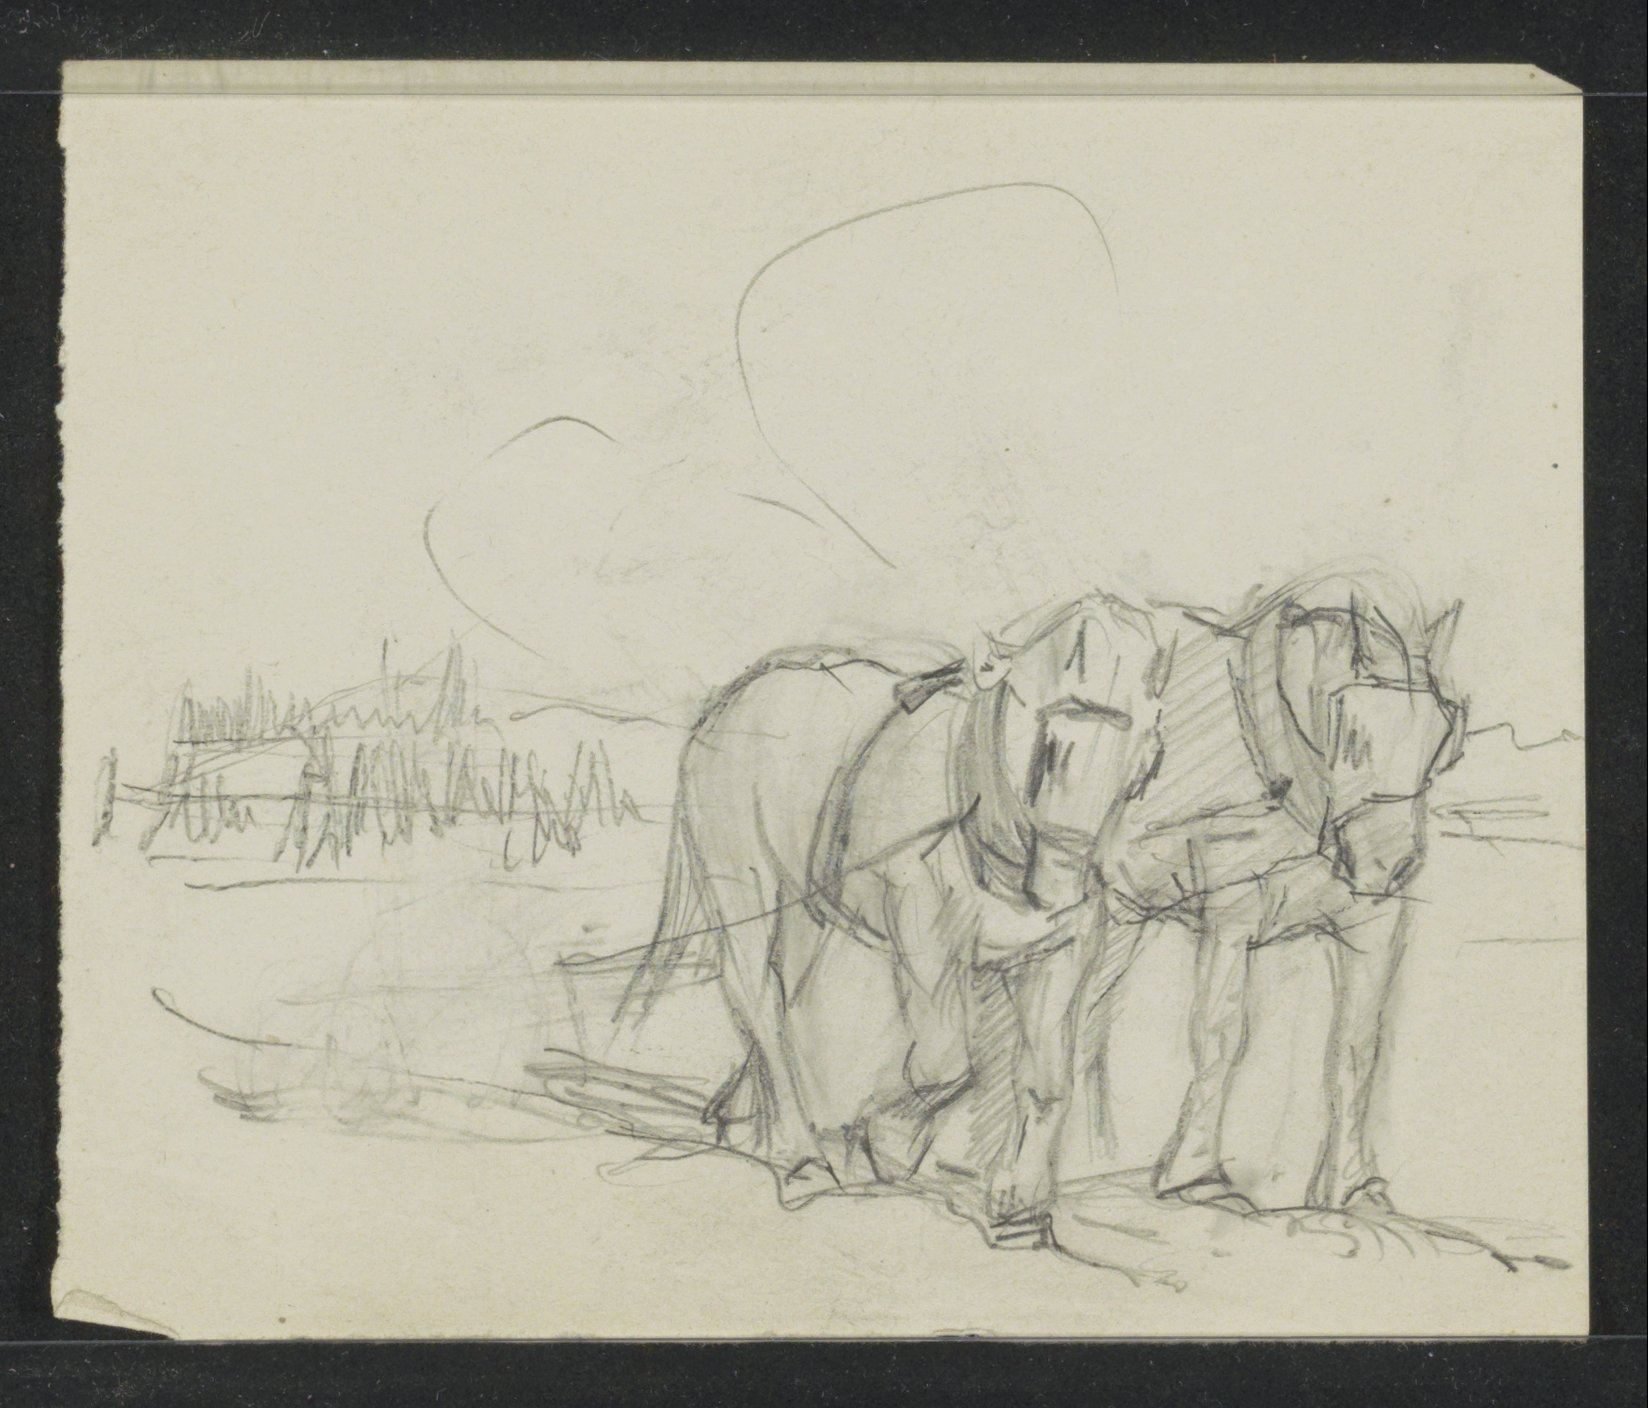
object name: sketchbook leaf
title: Twee ploegende paarden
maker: johanna van de kamer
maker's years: 1873-1922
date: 1883-1922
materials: paper, pencil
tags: horse, ploughing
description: Losse tekening tussen blad 27 en het achterste schutblad van een schetsboek met 27 bladen.